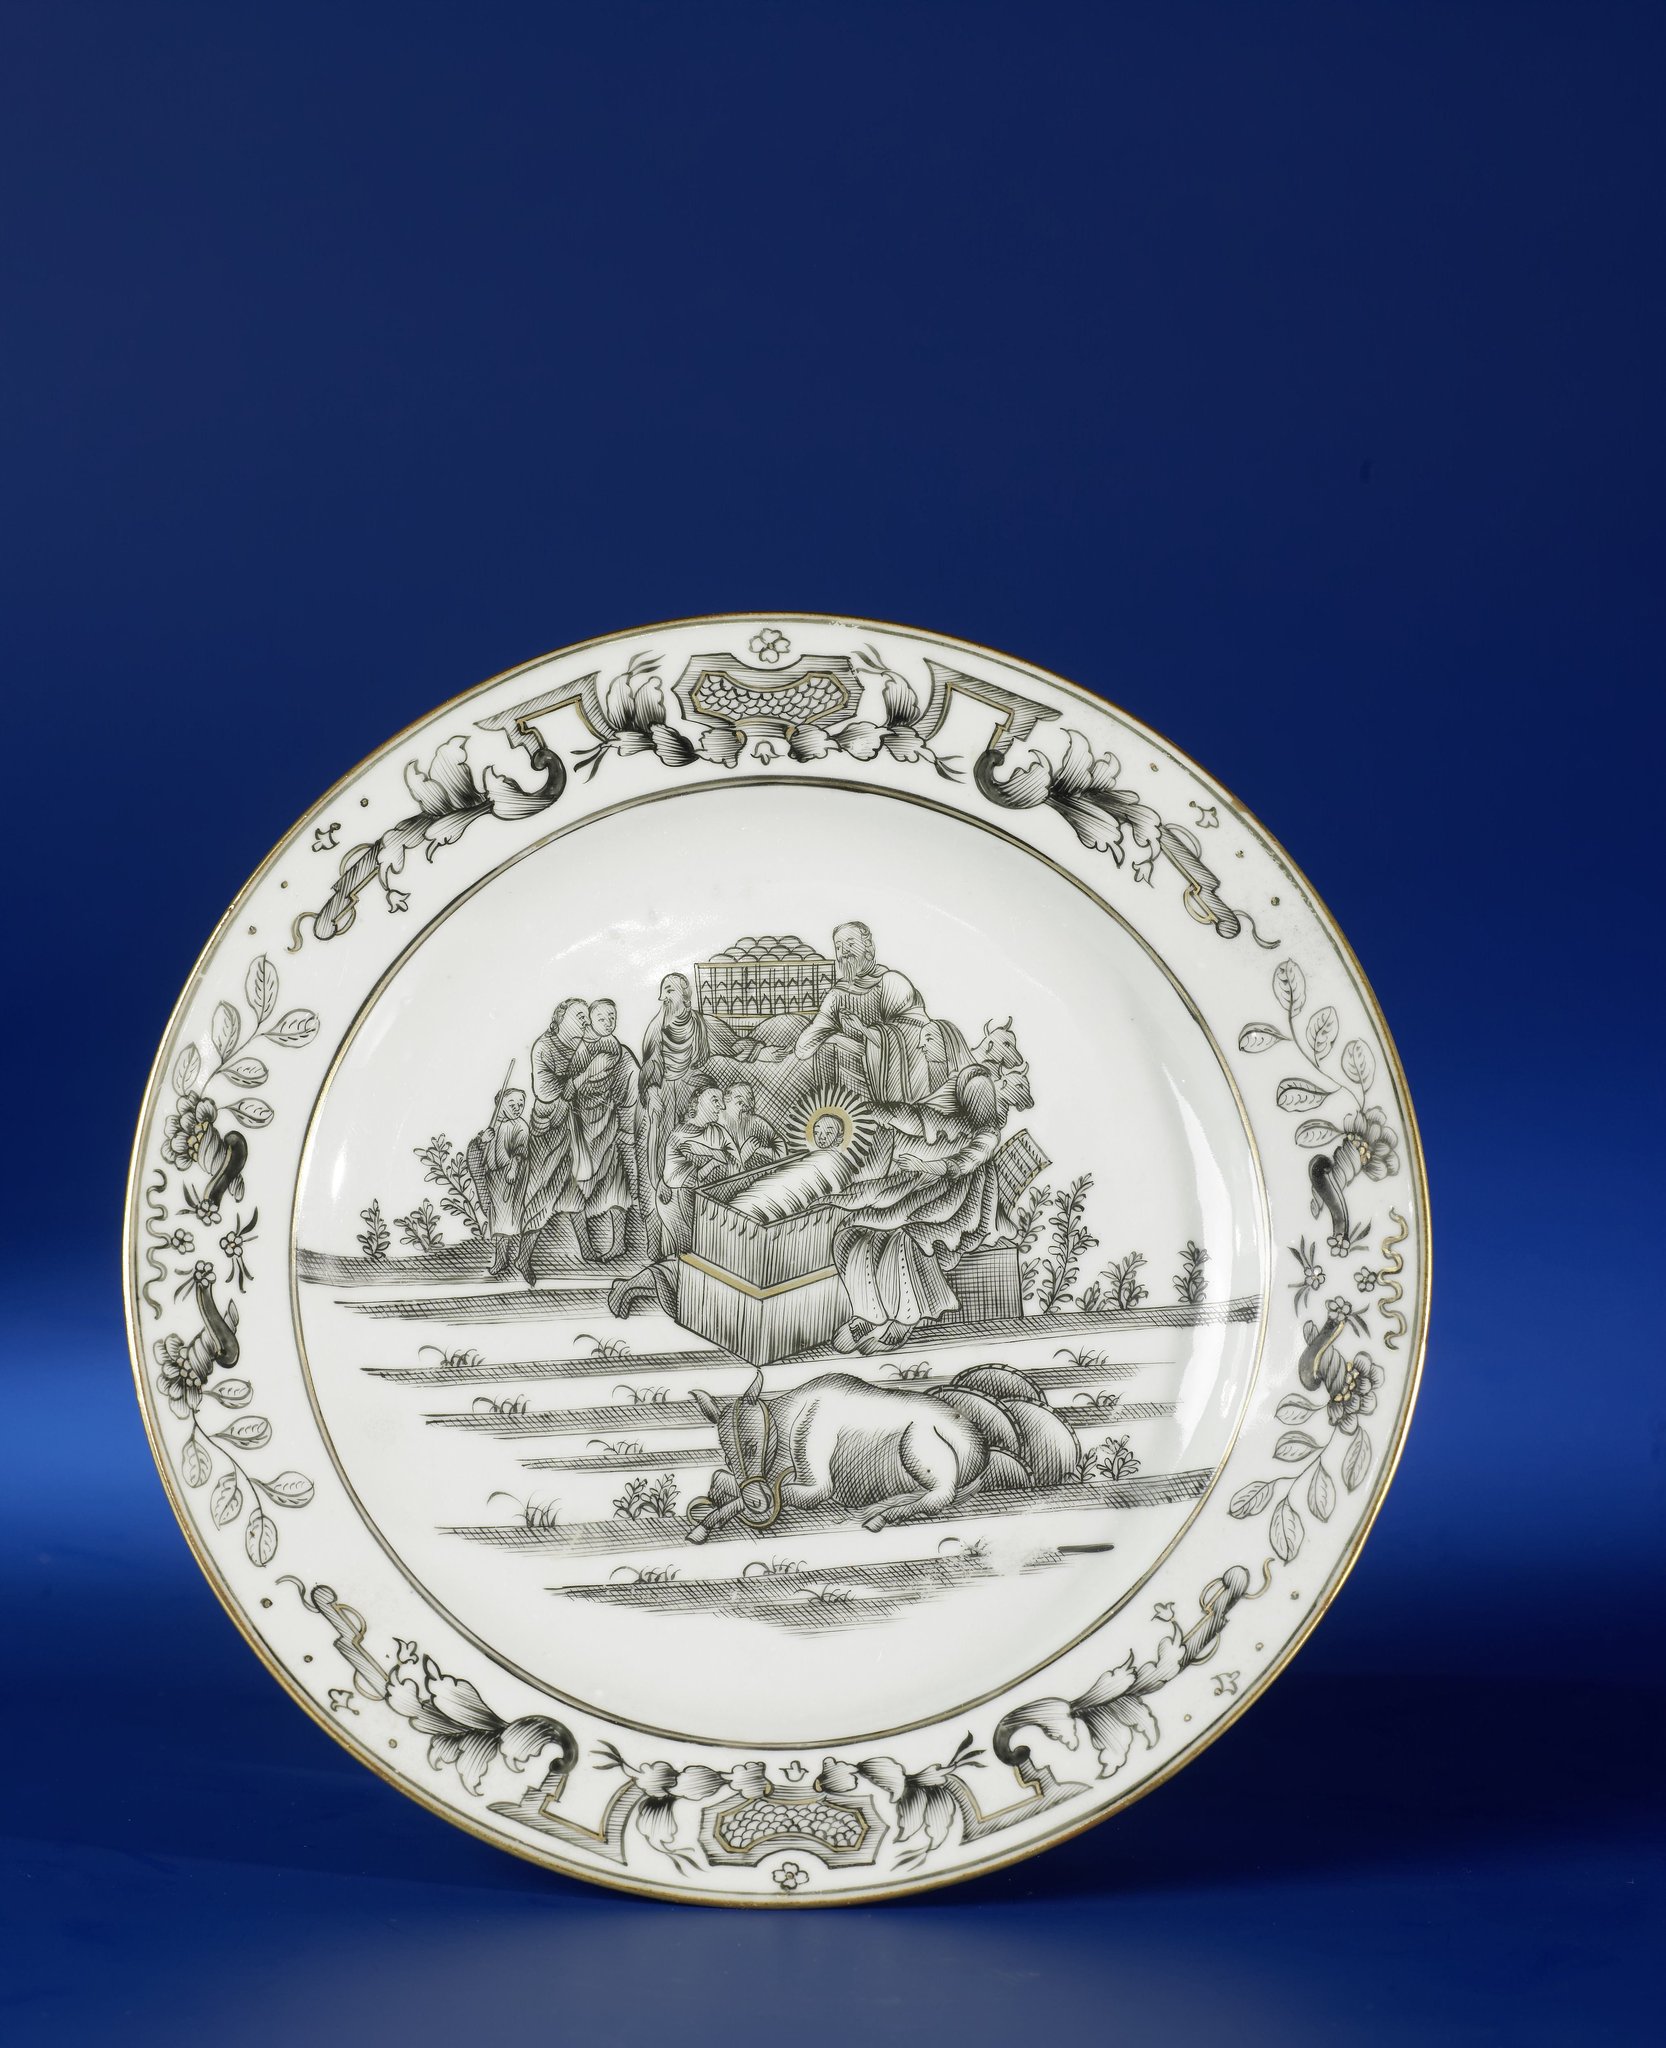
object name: plate dish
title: Plate with an image of the Nativity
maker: Anonymous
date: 1740-1760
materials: glaze, gold, paint, porcelain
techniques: firing, gilding, turning, vitrification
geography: china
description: AK-NM-6410 bord met Geboorte van Christus • Encre de Chine • Onderdeel van Royers porseleincollectie Royer had drie borden, beschilderd in encre de Chine, met christelijke voorstellingen naar prenten van Jan Luyken: Geboorte (AK-NM-6410), Kruisiging (AK-NM-6411) en Opstanding (AK-NM-6412). Er is vaak enige onzekerheid over de vraag of stukken porselein wel echt tot Royers porseleinverzameling behoorden (en niet later onopgemerkt daaraan zijn toegevoegd). Die twijfel is er in dit geval niet, aangezien we over aanvullende aanwijzingen beschikken. Gerard Bruining schreef in 1816 een beschrijving van de stad Den Haag. Hij besteedde hierin ook (nog) aandacht aan de collectie van Royer en over diens porselein schreef hij dat er onder andere te vinden waren: ‘(…) des morceaux relatifs à l’histoire de l’Évangile et qui paraissent avoir peints par des Chinois convertis (…).’ [Bruining 1816, p. 298]. Die christelijke voorstellingen spraken in de vroege 19de eeuw kennelijk tot de verbeelding, want ook de eerste directeur van het Kabinet van Zeldzaamheden, het museum waarin Royers Chinese collectie en porselein na de dood van zijn weduwe terecht kwam, meldde in de eerste gids die hij voor het museum schreef: ‘Drie borden, vóór de uitroeiing van het kristendom aldaar [hij bedoelt hier Japan want hij bespreekt deze borden als onderdeel van het kabinet ‘kostbare Japansche porseleinen’] gemaakt, waarop de geboorte, de dood en de opstanding van den Zaligmaker’ [Van de Kasteele 1824, p. 76]. De fascinatie voor Chinees porselein dat geheel naar een Europees voorbeeld is gemaakt past ook bij de late 18de eeuw. In haar reisverslag dat in 1791 werd gepubliceerd, noteerde de Duitse schrijfster Sophie von LaRoche (1730-1807) wat een Nederlandse porseleinhandelaar haar vertelde: ‘Diese Handelsherren schicken jetzt Zeichnungen nach China und Japan, weil diese Nationen in keines Sache etwas neues erfinden, oder für sich machen, und die neue Zeichnungen den ostindischen Porcellanhandel einen neuen Schwung geben.‘ [Von LaRoche 1791, p. 138]. Eigenlijk is dit een late observatie voor iets dat al decennia aan de gang was, maar de minachting voor het inventieve vermogen van de Aziatische landen past wel weer bij algemene opinie van die heel late 18de eeuw. Voor Royer zal dit waarschijnlijk anders zijn geweest. Hij was juist wél geïnteresseerd in China en zal dus níet gedacht hebben dat zij alleen nog iets interessants konden maken als zij exact een opgestuurd voorbeeld navolgden. Maar zijn accent op oud en niet op eigentijds porselein sluit wel weer aan op deze algemene tendens. Nu dient de vraag zich aan of Royer het prentvoorbeeld voor deze borden kende. Christiaan Jörg stelde vast dat de prenten afkomstig zijn uit een geïllustreerde Luther-bijbel [Jörg 2002]. Royer had in zijn grote bibliotheek wel verschillende geïllustreerde bijbels [Catalogue….1816, oct. 38 (p. 70)/oct. 78 (p. 71)], maar zij zijn te summier omschreven om vast te stellen welke dat precies waren. Royer was echter niet Luthers dus de kans dat hij de bijbel met deze illustraties had, is niet bijzonder groot. Luyken publiceerde de prenten echter ook in losse prentboeken: ‘Bijbelprenten’ en ‘Schriftuurlijke Geschiedenissen’ [Van Eeghen en Van der Kellen 1905, vol. I, pp. 25-28]. Ook hiervan is het moeilijk vast te stellen of Royer precies deze werken in zijn bezit had. Volgens de catalogus van zijn bibliotheek had hij een grote groep geïllustreerde werken van Luyken [Catalogue…1816, oct. 1490 (p. 125)], maar ook hier ontbreken de specificaties. Ook in Royers prentcollectie (nu in het prentenkabinet van Universiteit Leiden) komen deze Luyken-prenten niet voor (vriendelijke mededeling conservator Jef Schaaps). Eigenlijk is dit erg teleurstellend omdat in deze borden Royers liefde voor China, porselein, prentkunst, en theologie samenkomen, en we toch niet – hoe veelbelovend de vraag en de bronnen er ook uitzagen – kunnen vaststellen dat hij met zijn collecties exacte verbanden kon leggen. Hoe dan ook. Hij zal begrepen hebben dat een Nederlandse prent in China werd nageschilderd. Dat is eigenlijk meer dan genoeg. Bronnen: S.W. von LaRoche, Tagebuch einer Reise durch Holland und England, Offenbach an Main, 1791. G. Bruining, Déscription succinte, mais complette, de l’état actuel de la Haye, et de ses environs, Royttrdam 1816. R.P. van de Kasteele, Handleiding tot de bezigtiging van het Koninklijk Kabinet van Zeldzaamheden(…), Den Haag, 1824. P. van Eeghen en J.P. van der Kellen, Het werk van Jan en Caspar Luyken, Amsterdam, 1905. Christiaan Jörg, ‘A Pattern of Exchange: Jan Luyken and “Chine de Commande” Porcelain’, Metropolitan Museum Journal 37 (2002), pp. 171-176. Tussen 1745 en 1750 waren religieuze scènes zeer populair. Naast de Geboorte werden ook de Kruisiging, de Opstanding en de Hemelvaart veelvuldig op porselein aangebracht, zowel polychroom als in encre de Chine. Tenminste acht varianten van de randen zijn bekend. De polychrome exemplaren bij deze borden zijn zeldzamer dan de exemplaren in encre de Chine. Naast borden zijn er ook onderdelen van thee-, koffie- en chocoladeserviezen met deze vier voorstellingen bekend. Kommen, soepborden of schalen en andere serviesonderdelen ontbreken. Aangenomen kan worden dat de borden voornamelijk een decoratieve functie hadden. Christus ligt in de kribbe terwijl Maria, Jozef en enkele herders (?) toekijken. Op de achtergrond twee schapen en op de voorgrond een ezel. De scènes in deze serie zijn nauwgezette kopieën van prenten die de Amsterdamse dichter en graveur Jan Luyken (1649-1712) maakte voor verschillende edities van de Lutherse Nederduytse Bijbel.